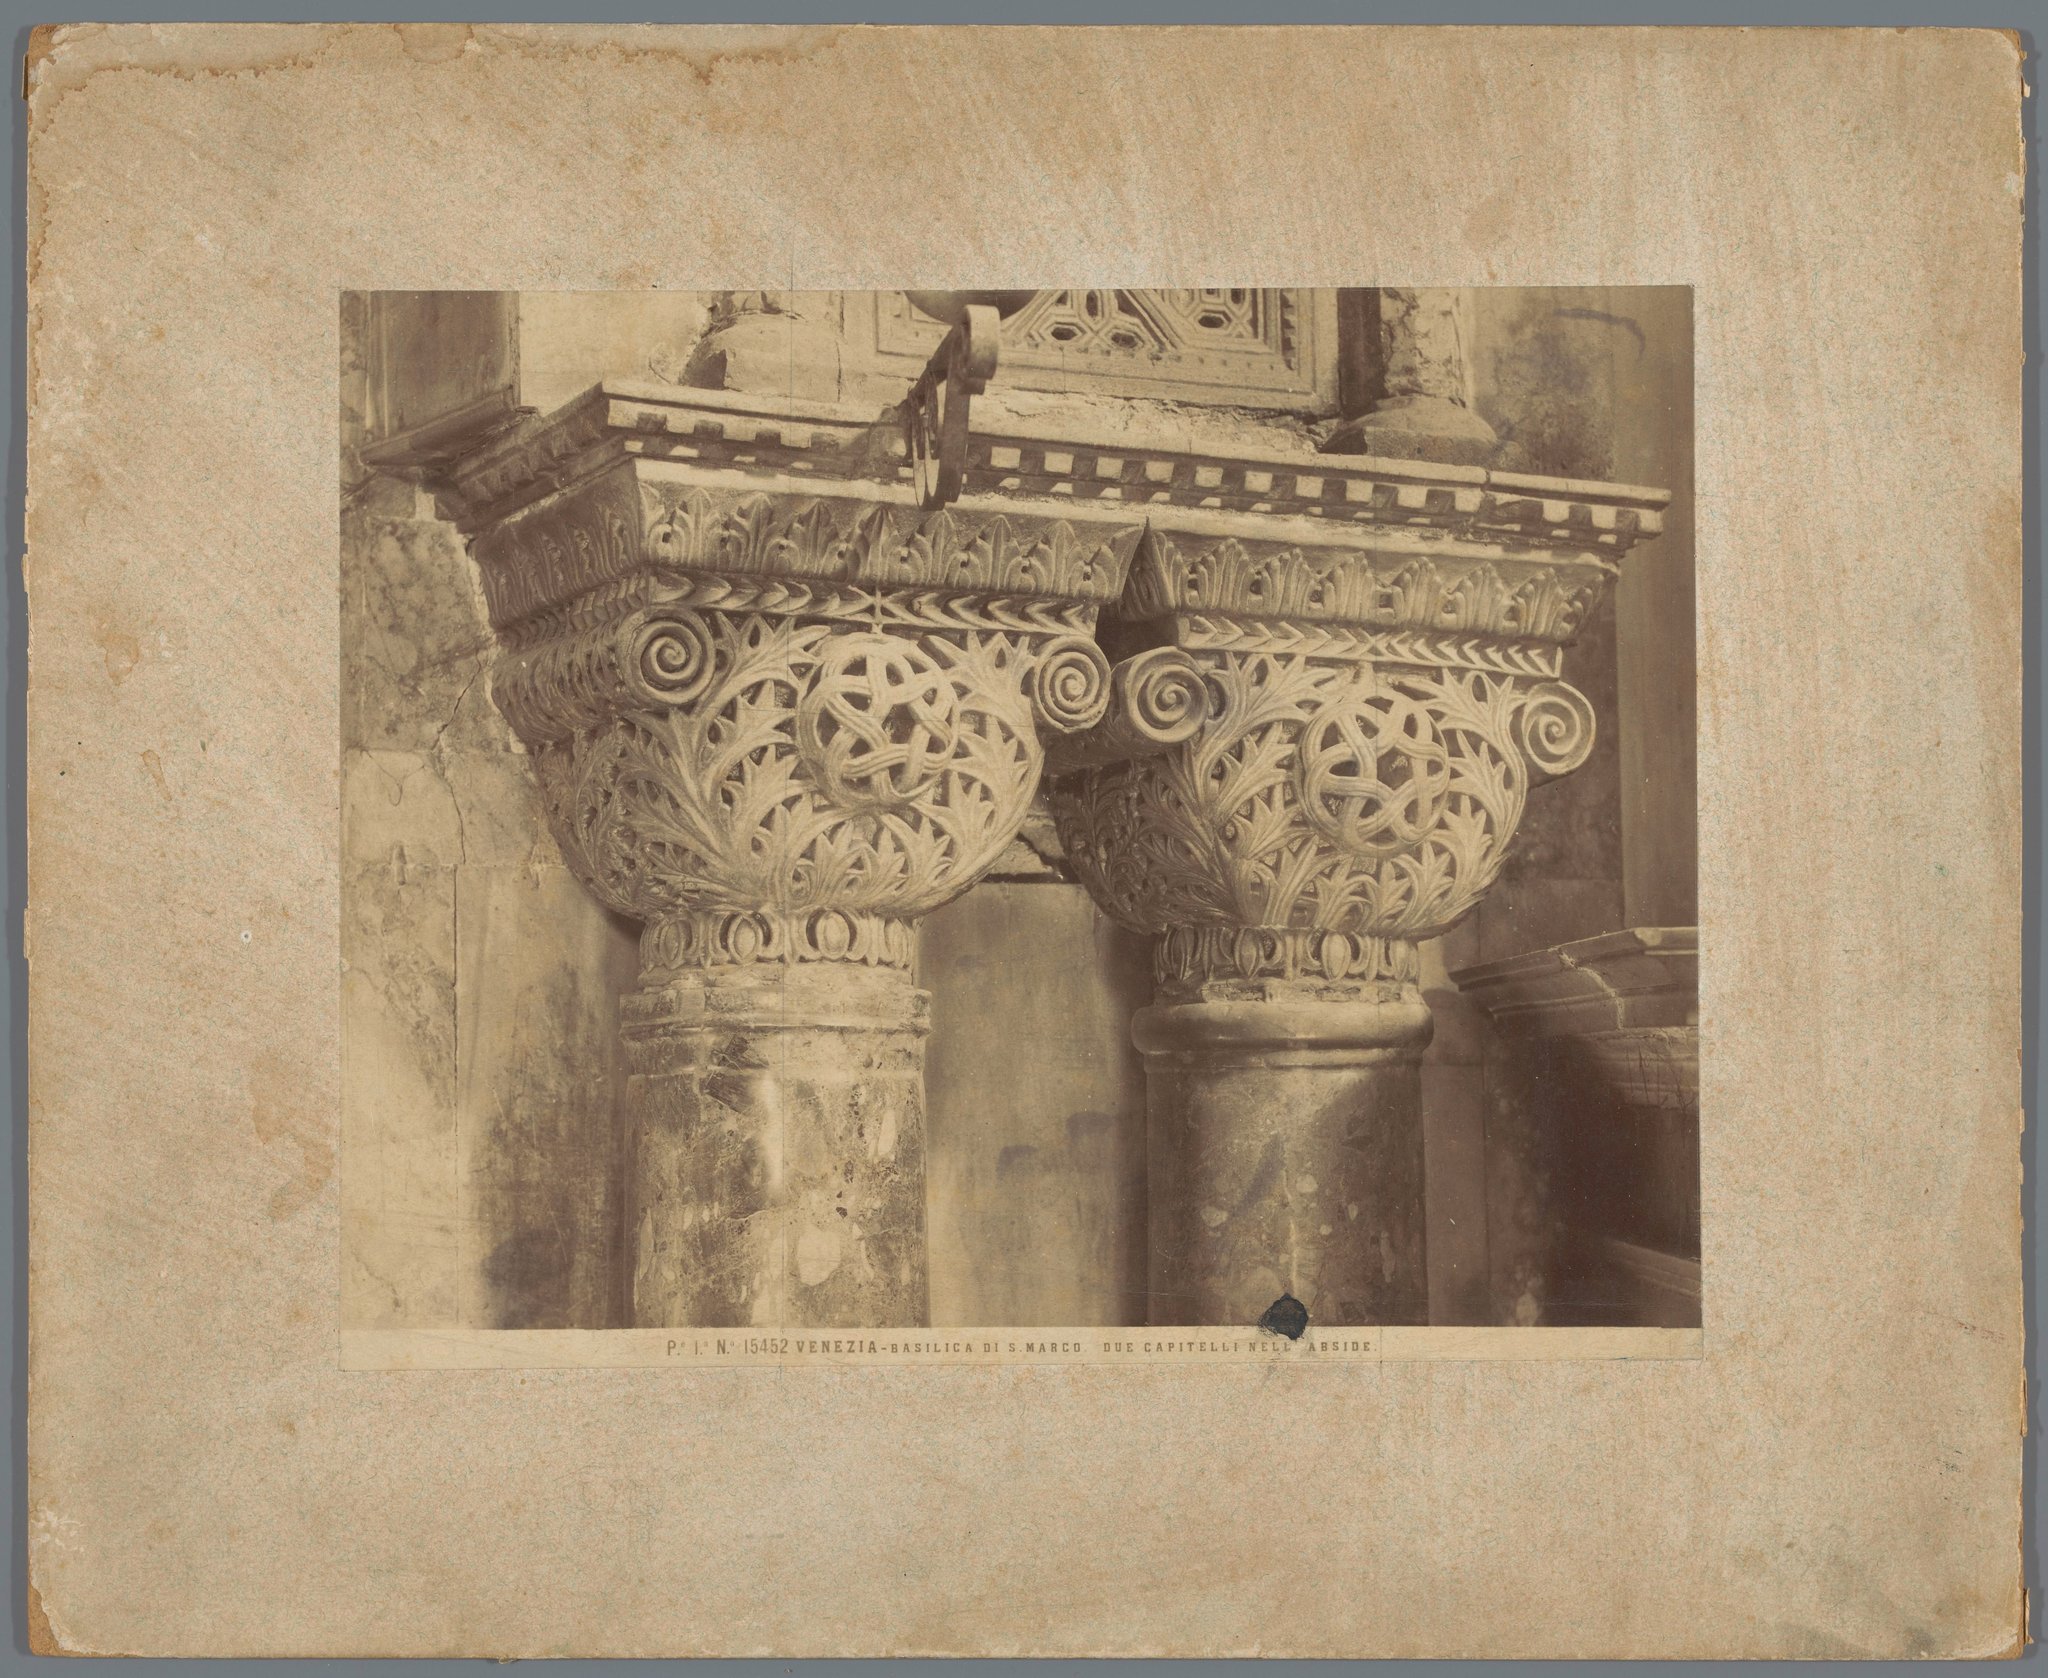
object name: photograph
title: VENEZIA-BASILICA DI S. MARCO DUE CAPITELLI NELL ABSIDE.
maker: Anonymous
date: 1875-1900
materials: cardboard, photographic support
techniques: albumen print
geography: st. mark's basilica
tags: capital (~ column, pillar), sculpture (+ relief ~ sculpture)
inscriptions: number: ‘P.e 1.a N.o 15452.’, collector's mark: ‘RIJKS-NORMAALSCHOOL VOOR TEEKENONDERWIJZERS-AMSTERDAM’